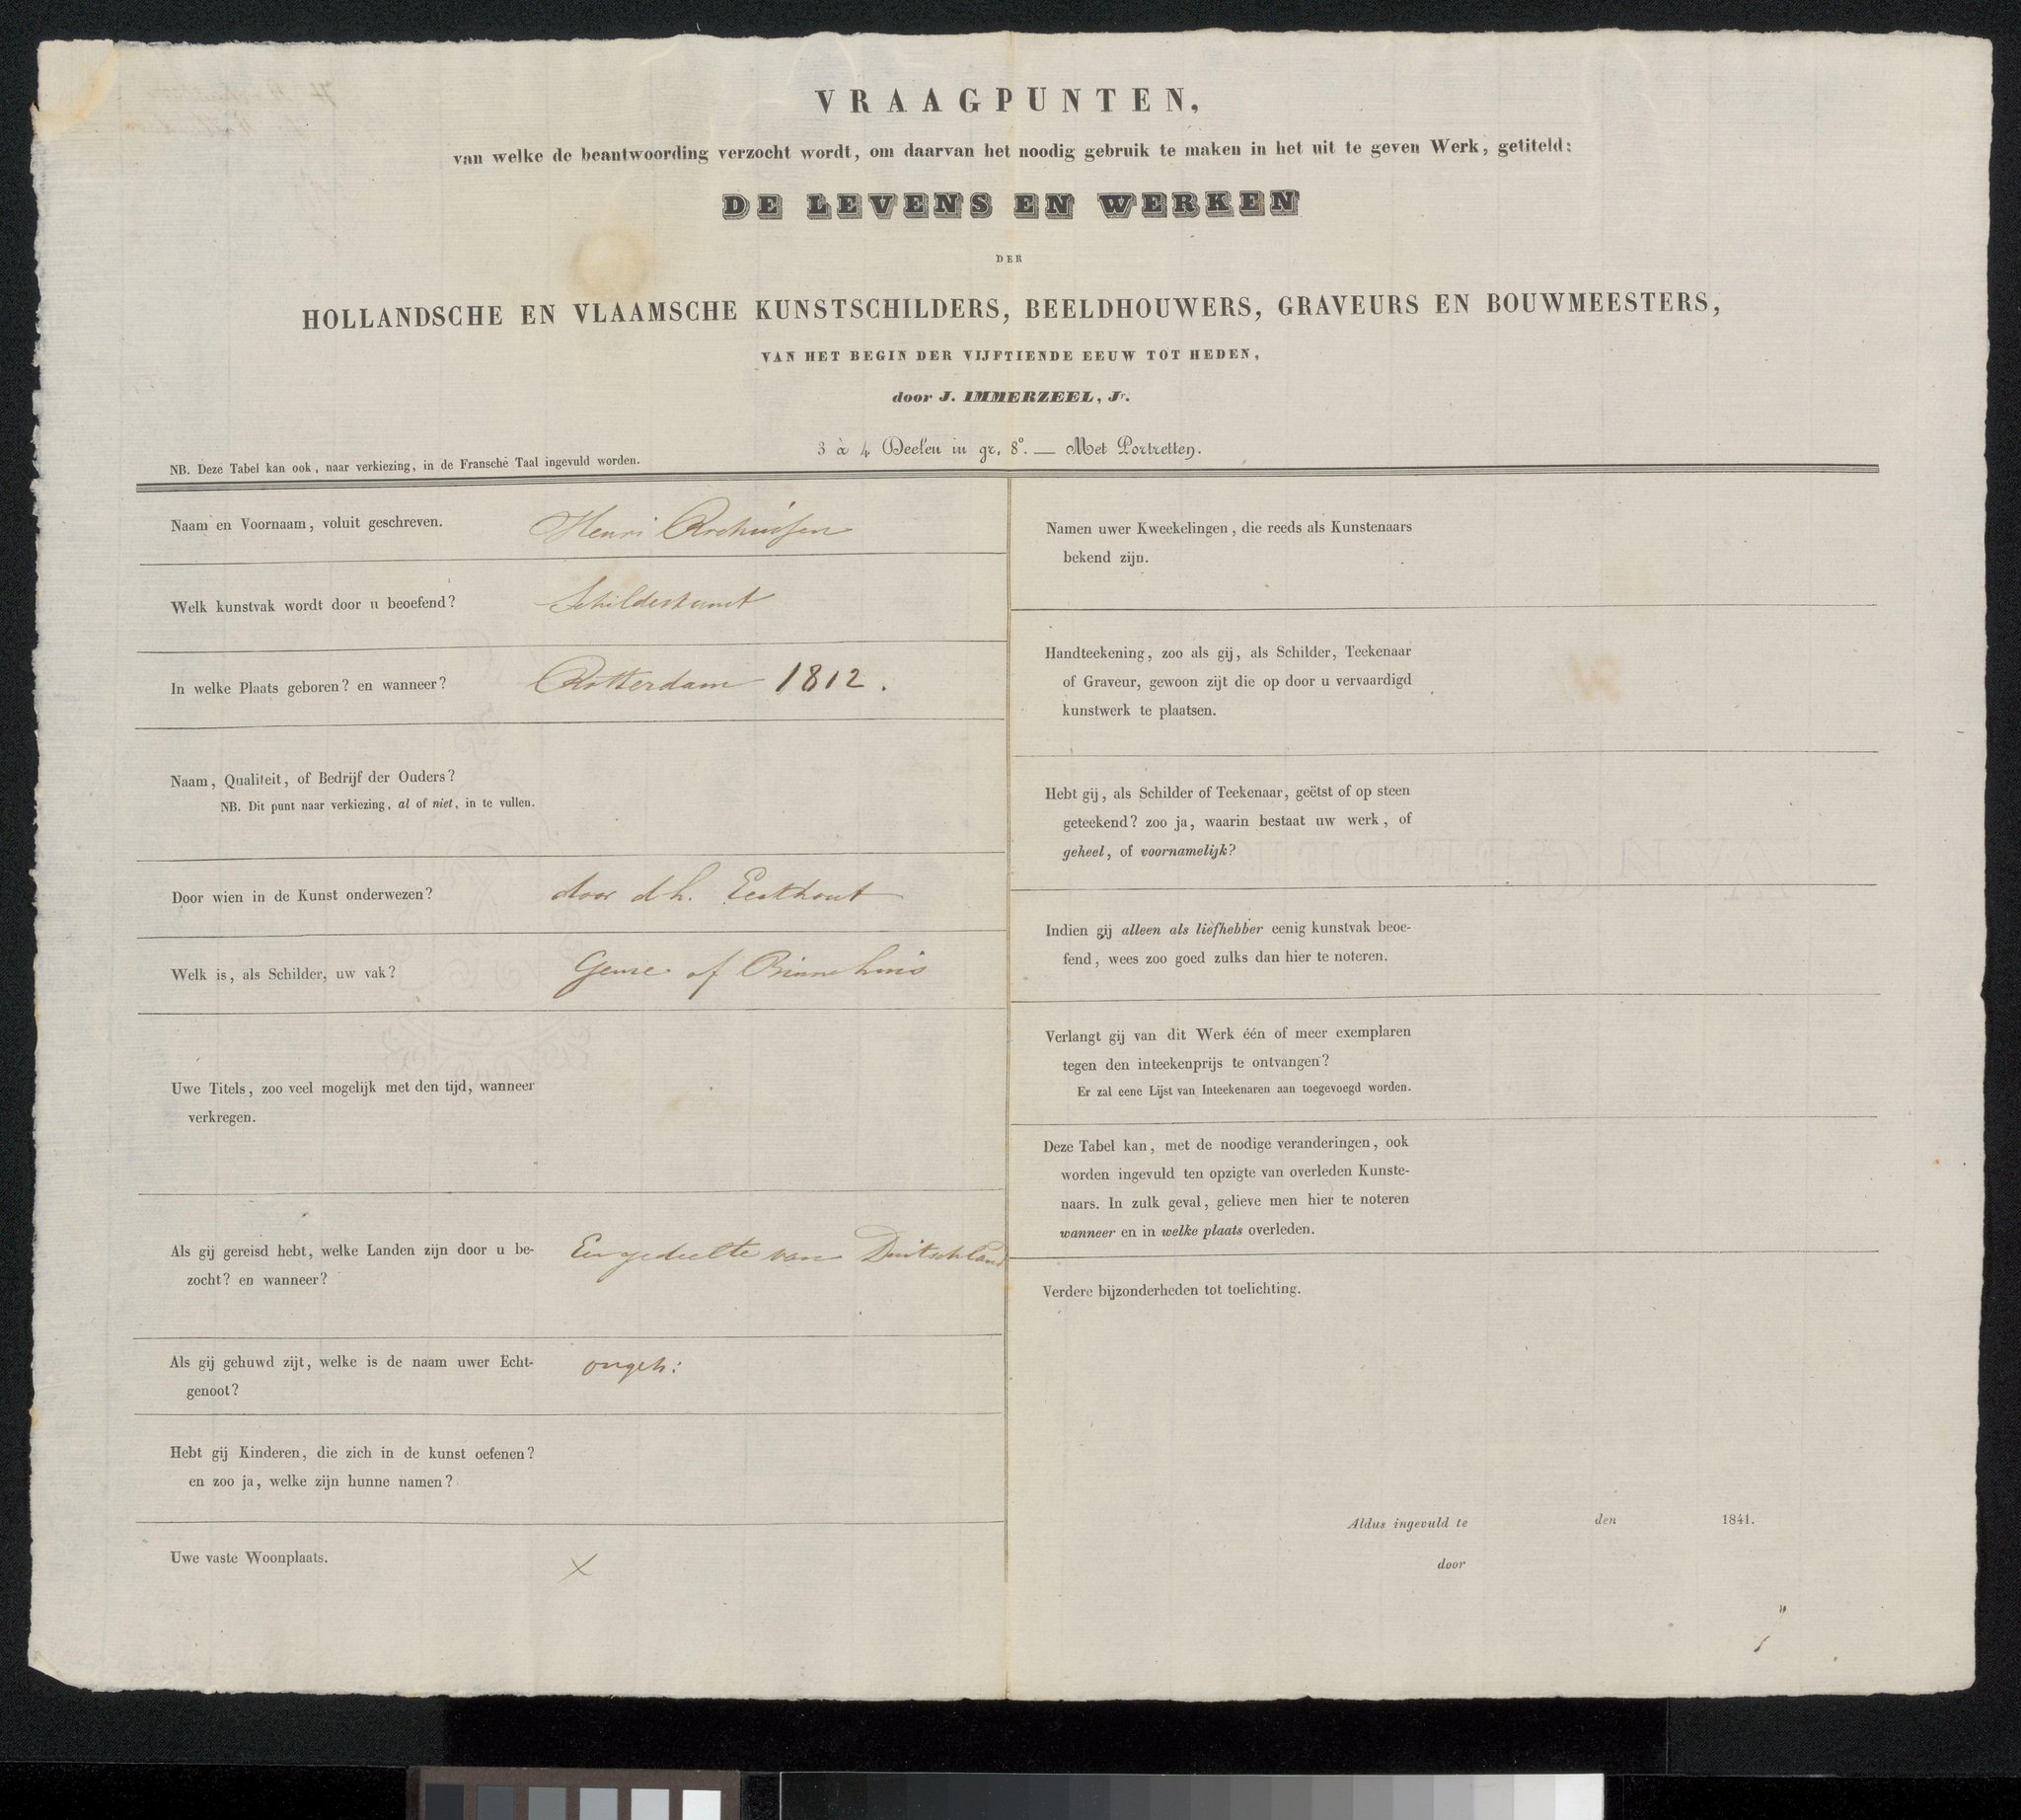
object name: questionnaire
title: Enquêteformulier ingevuld door Henri Rochussen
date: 1840-1841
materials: ink, paper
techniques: pen, printing, writing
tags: rotterdam, draughtsman, henri rochussen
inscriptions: inscription: ‘Vraagpunten,/ van welke de beantwoording verzocht wordt, om daarvan het noodig gebruik te maken in het uit te geven Werk, getiteld: De levens en werken/ der Hollandsche en Vlaamsche kunstschilders, beeldhouwers,/ graveurs en bouwmeesters, van het begin der vijftiende eeuw tot heden/ door J. Immerzeel, Jr.’, watermark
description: Opgenomen in: Immerzeel, J. Jr., De levens en werken der Hollandsche en Vlaamsche kunstschilders, beeldhouwers, graveurs en bouwmeesters, van het begin der vijftiende eeuw tot heden, Amsterdam: J.C. van Kesteren, 1842-1843.